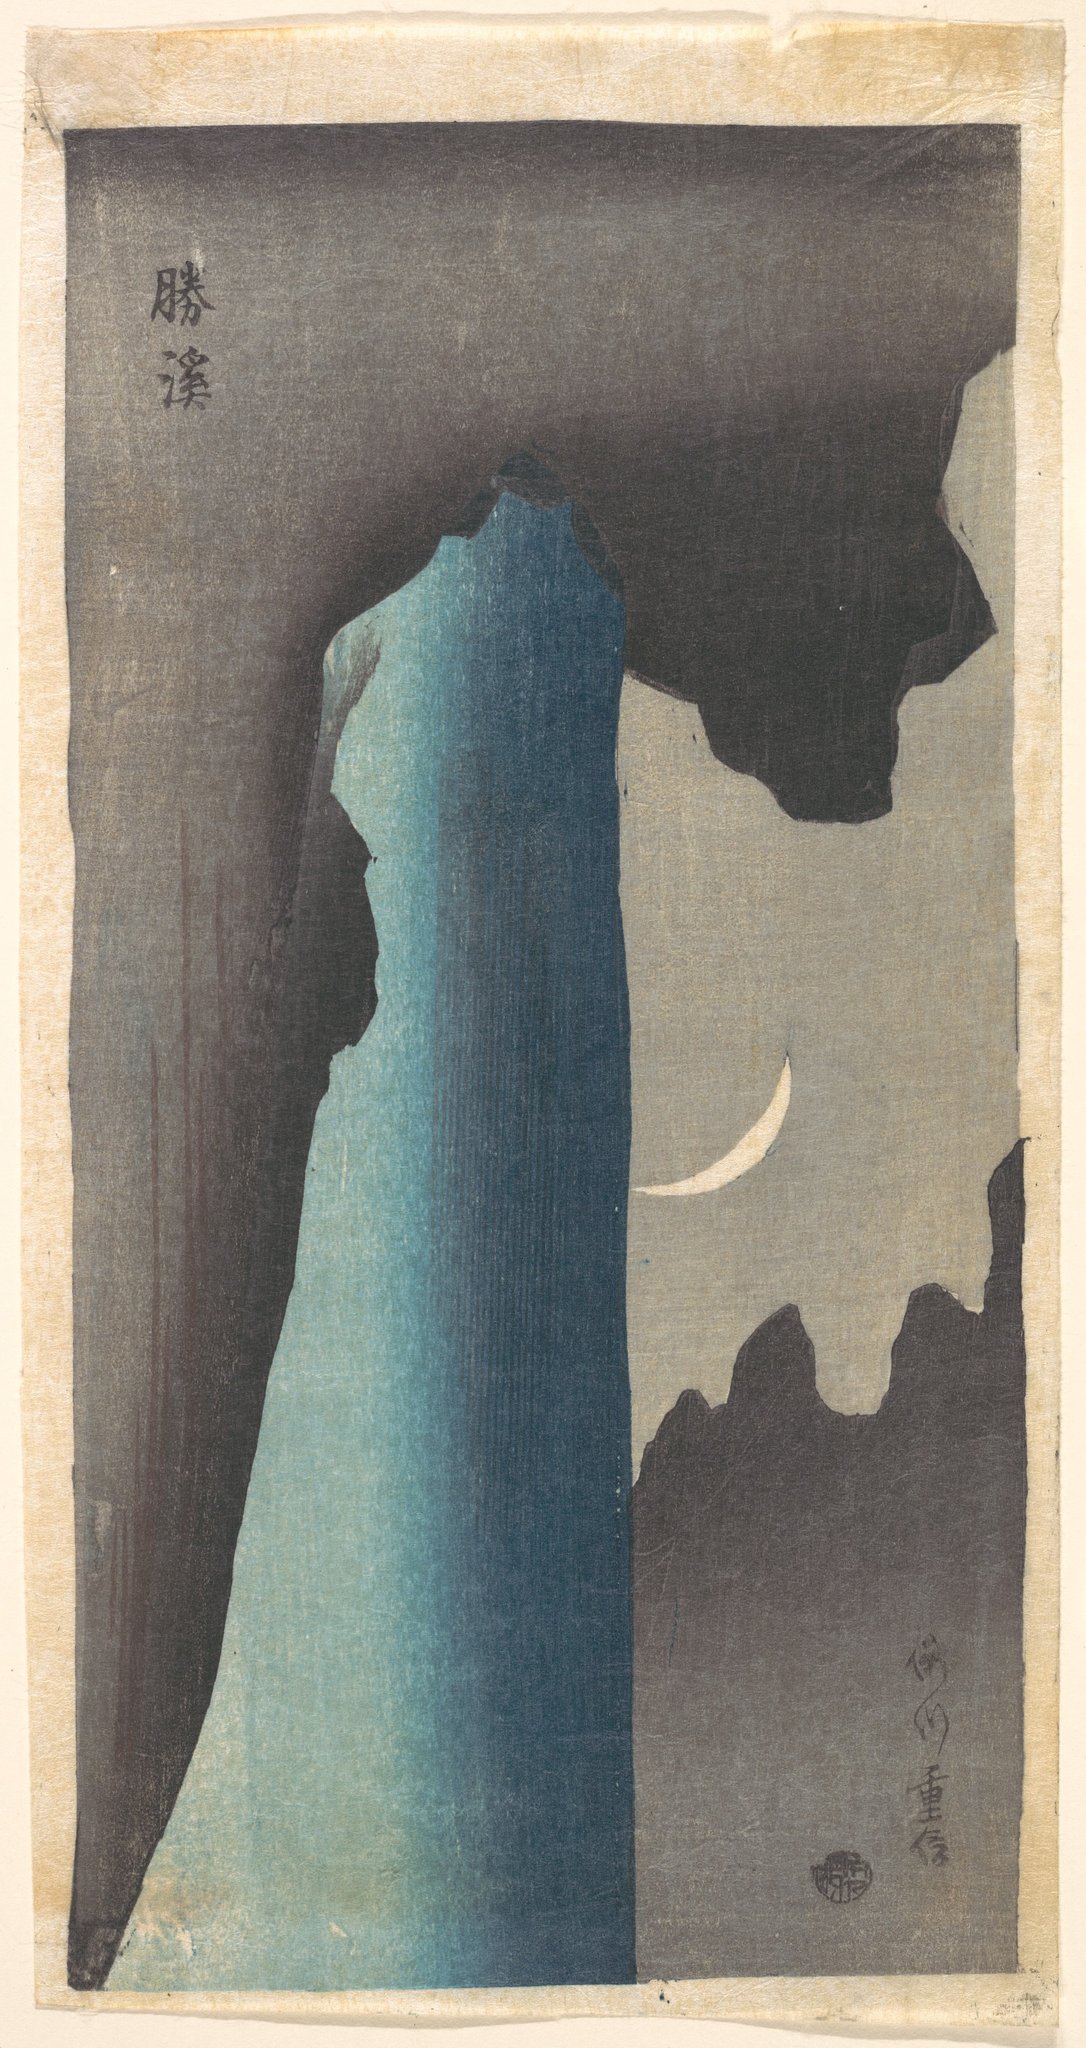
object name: print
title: Celebrated Waterfall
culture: japanese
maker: yanagawa shigenobu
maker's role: artist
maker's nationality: japanese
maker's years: 1787-1832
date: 1820-1830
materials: ink, paper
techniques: woodblock print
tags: waterfalls,moon